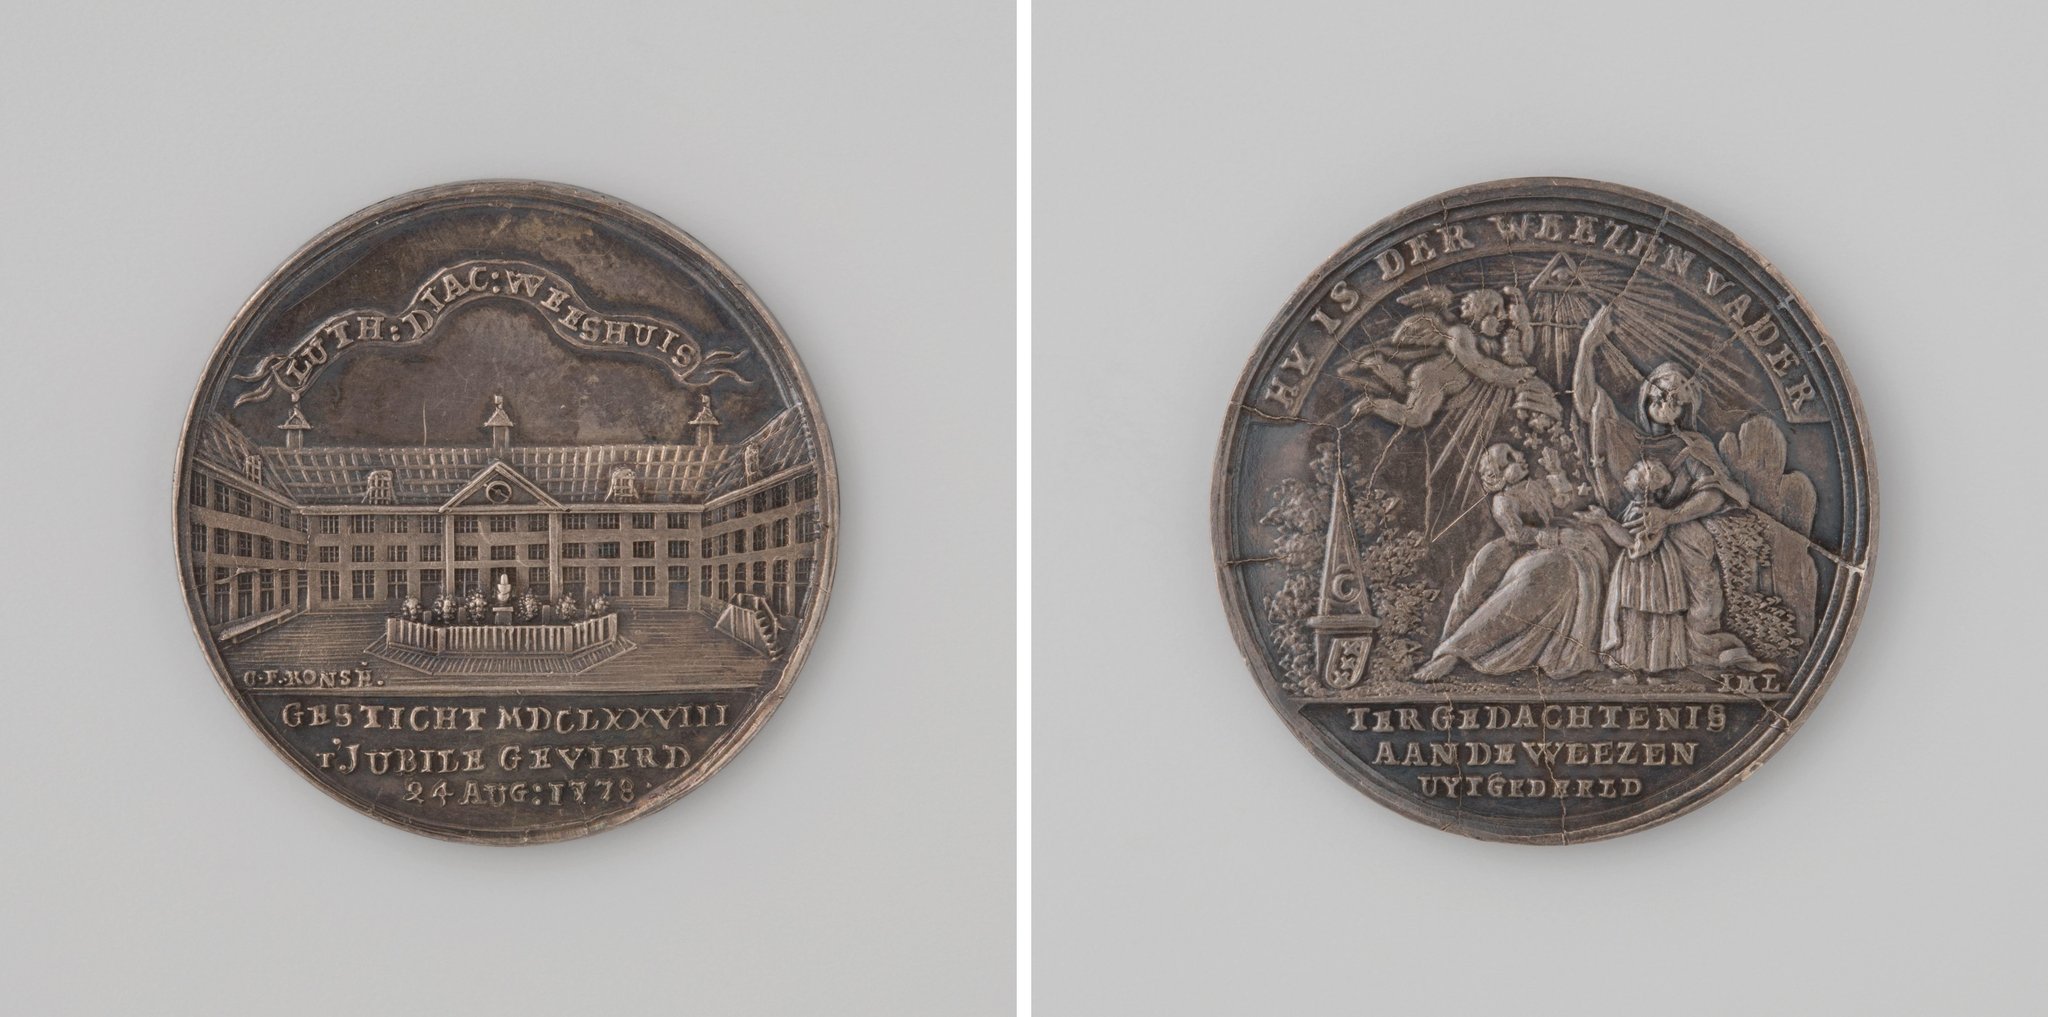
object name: history medal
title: Eerste eeuwfeest van de stichting van het Lutherse diaconieweeshuis te Amsterdam, penning aan de weeskinderen uitgedeeld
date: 1778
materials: silver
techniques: striking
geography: amsterdam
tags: amsterdam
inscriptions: circumscription: ‘HY IS DER WEEZEN VADER’, caption: ‘GESTICHT MDCLXXVIII/ 1e JUBILE GEVIERD/ 24 AUG:1778’, caption: ‘TER GEDACHTENIS/ AAN DE WEEZEN/ UYTGEDEELD.’, signature: ‘C.F. KONSÉ’, inscription: ‘LUTH. DIAC: WEESHUIS’